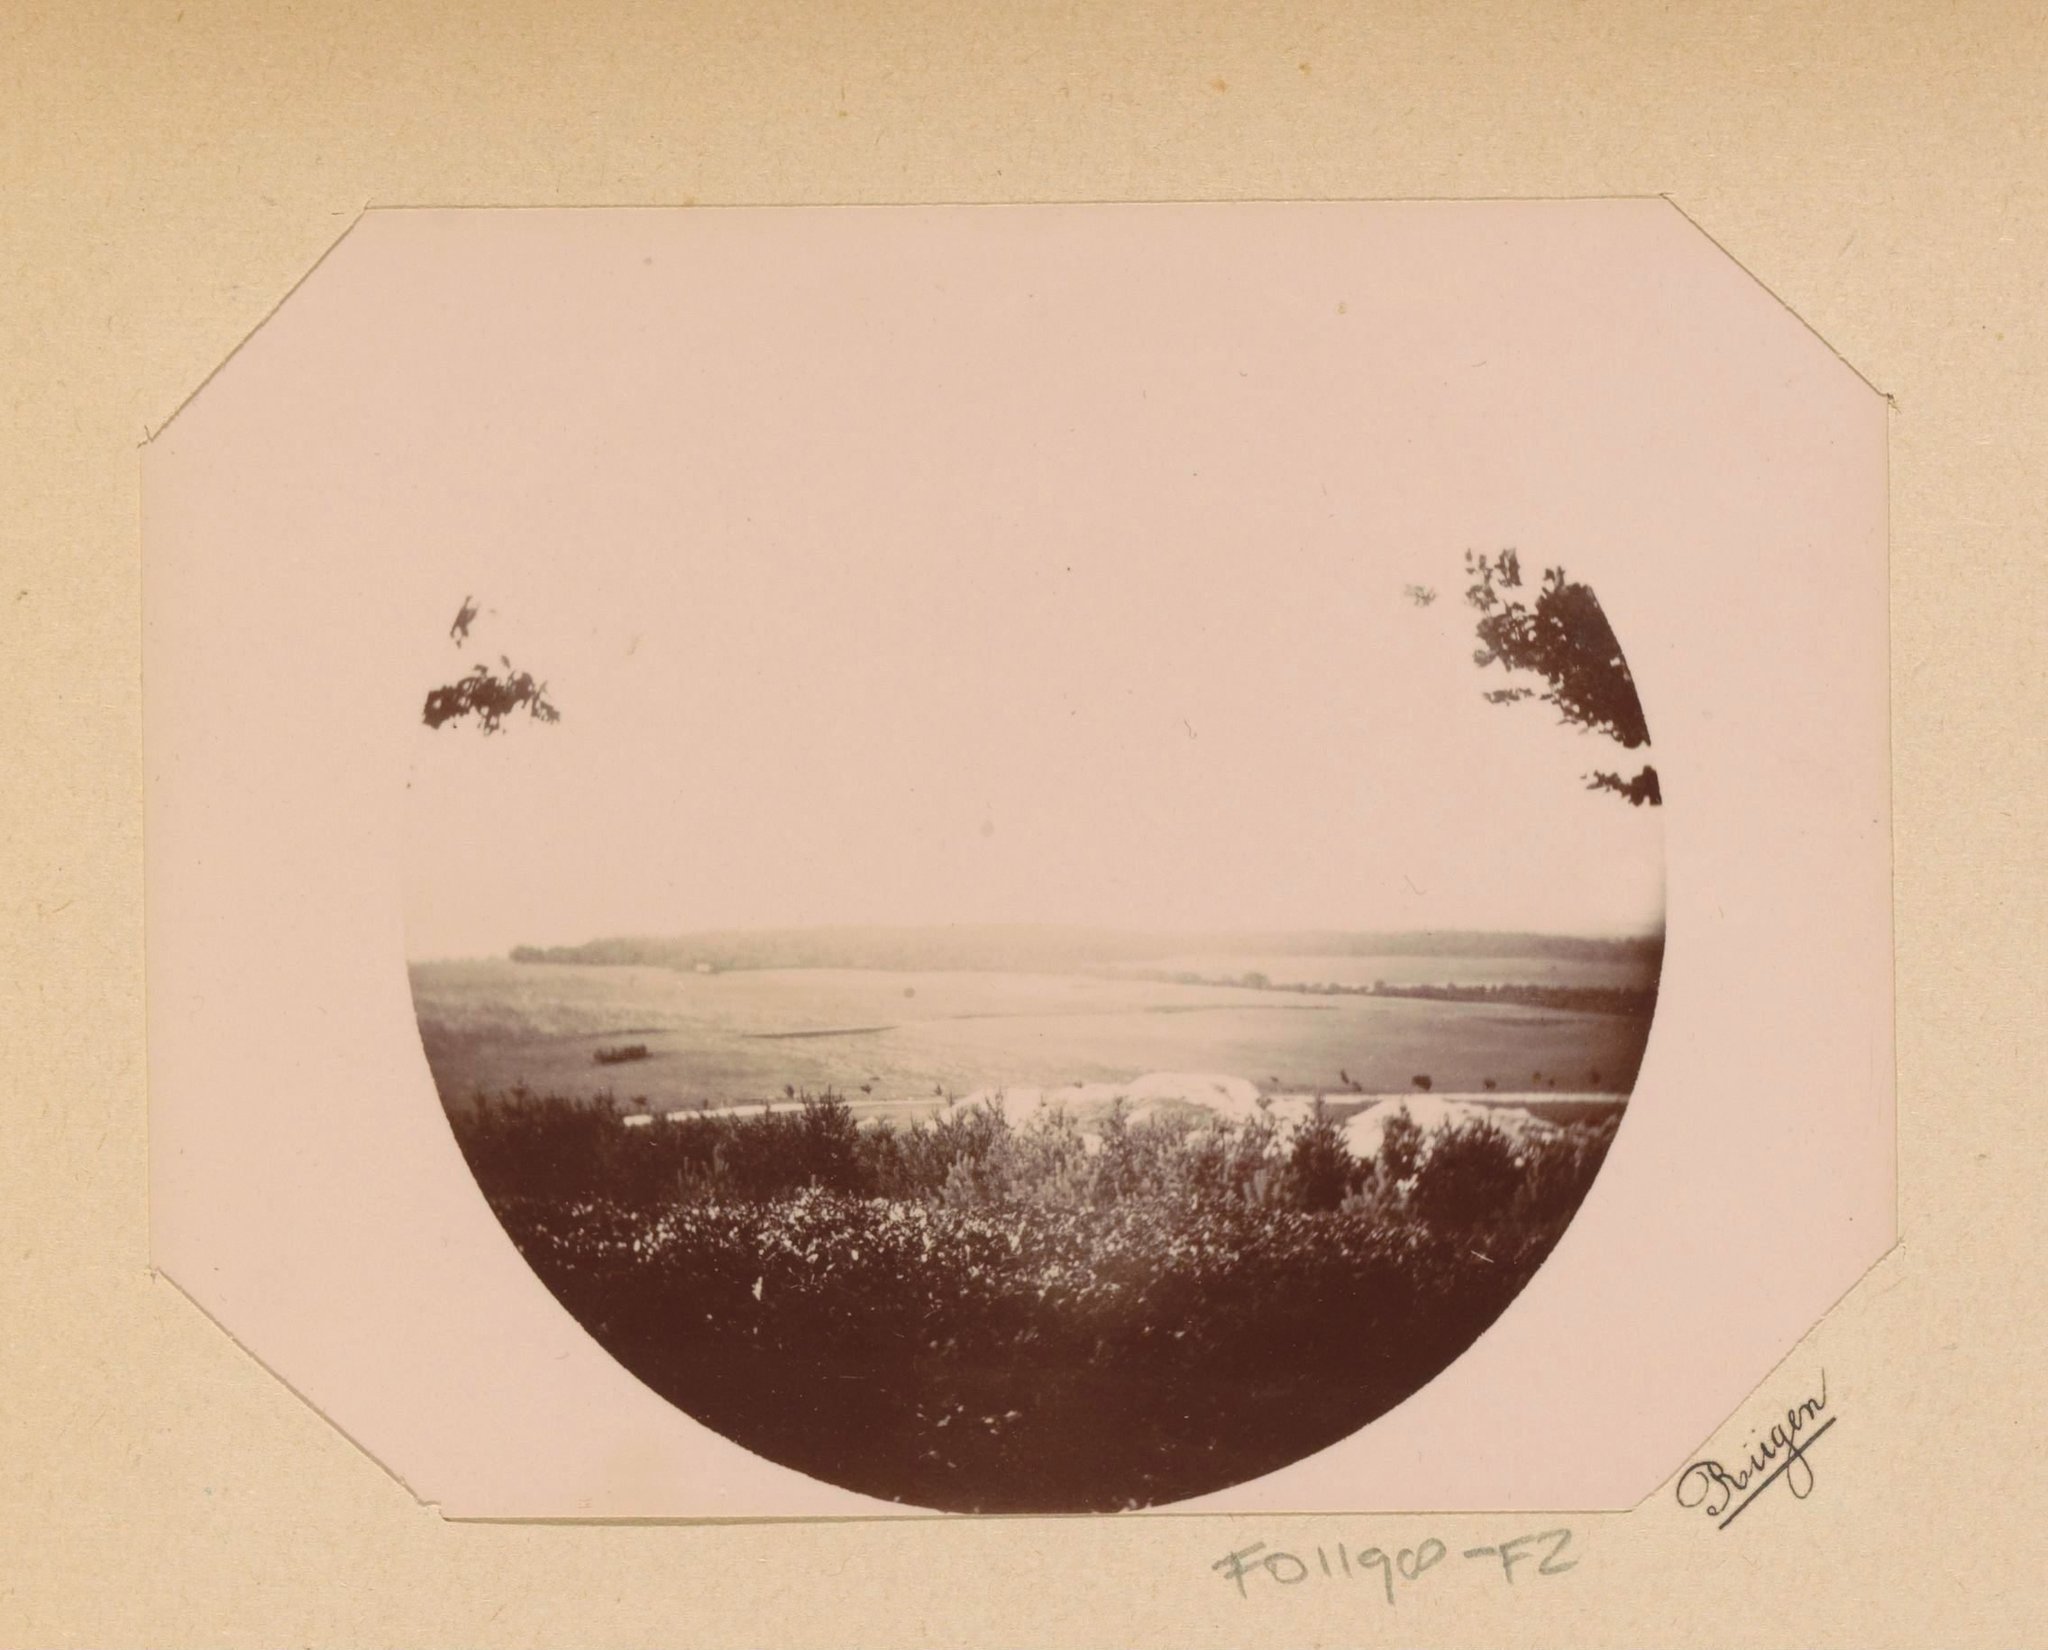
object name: photograph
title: Gezicht op Rügen in de Oostzee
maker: willem frederik piek jr.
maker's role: fotograaf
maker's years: 1874-1954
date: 1889-1893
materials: paper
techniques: gelatin silver print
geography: rügen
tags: island